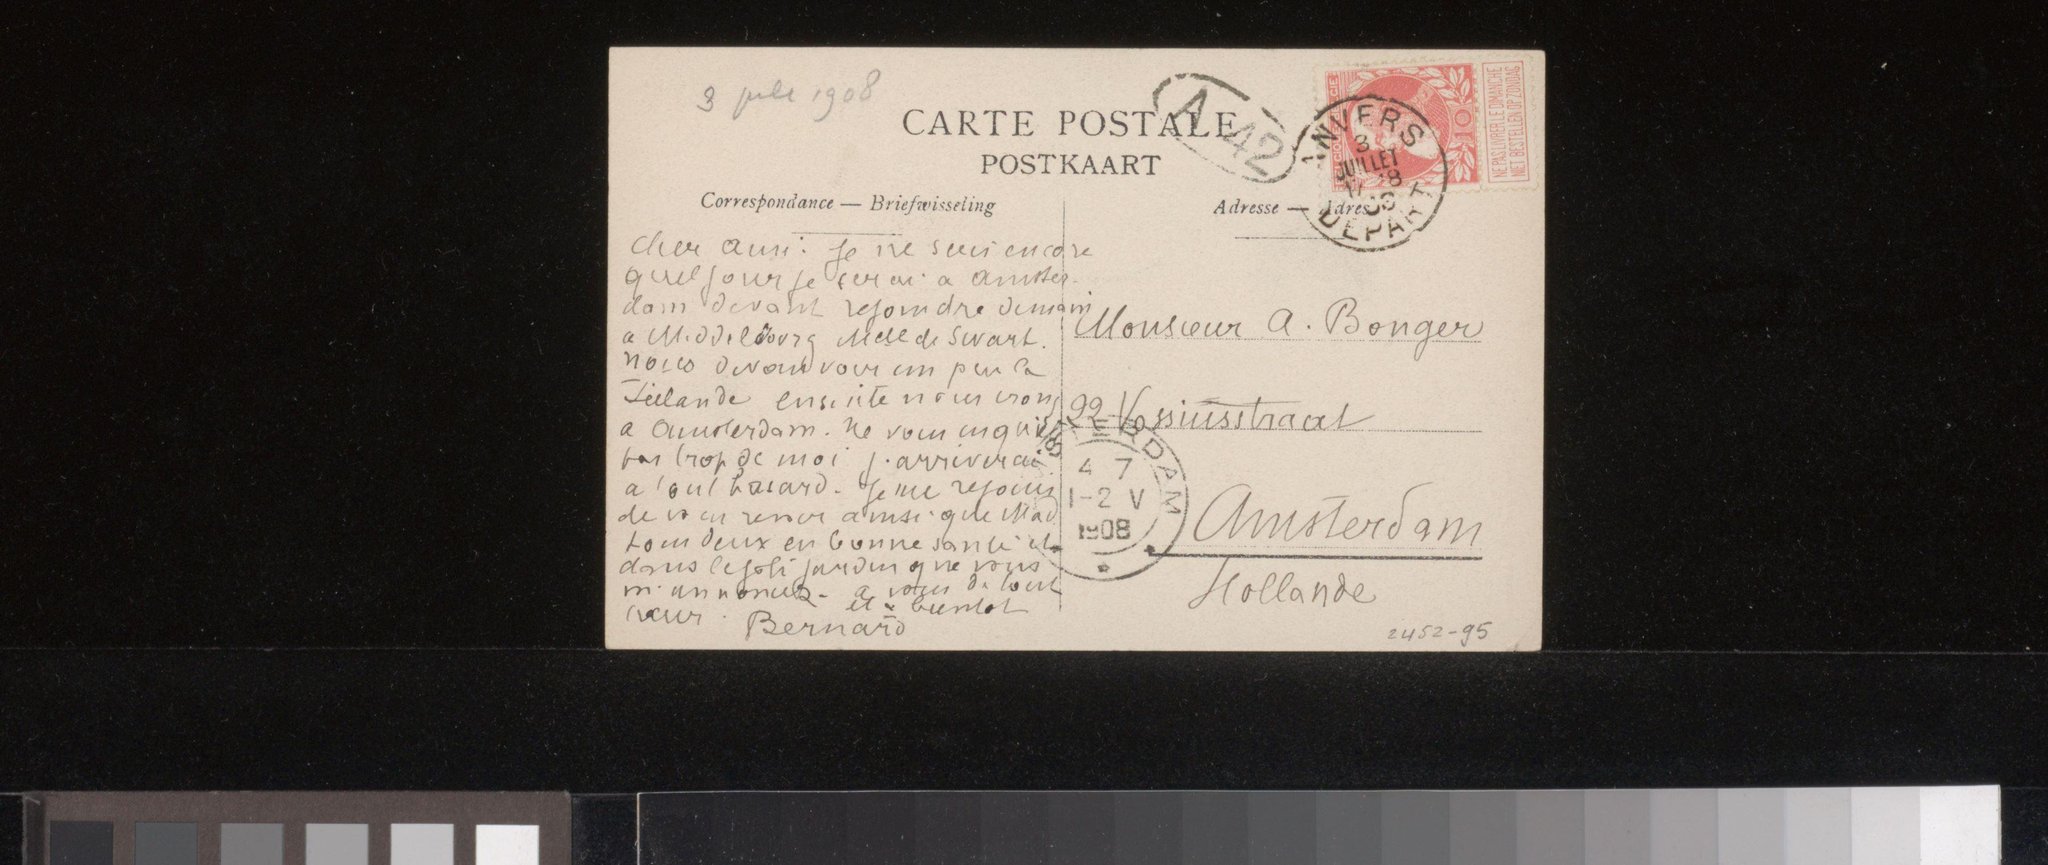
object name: ansichtkaart, prentbriefkaart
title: Prentbriefkaart aan Andries Bonger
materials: cardboard, ink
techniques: photograph, pen, writing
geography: antwerp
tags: andries bonger, anacapri, sculptor, saar de swart, zeeland, middelburg, amsterdam